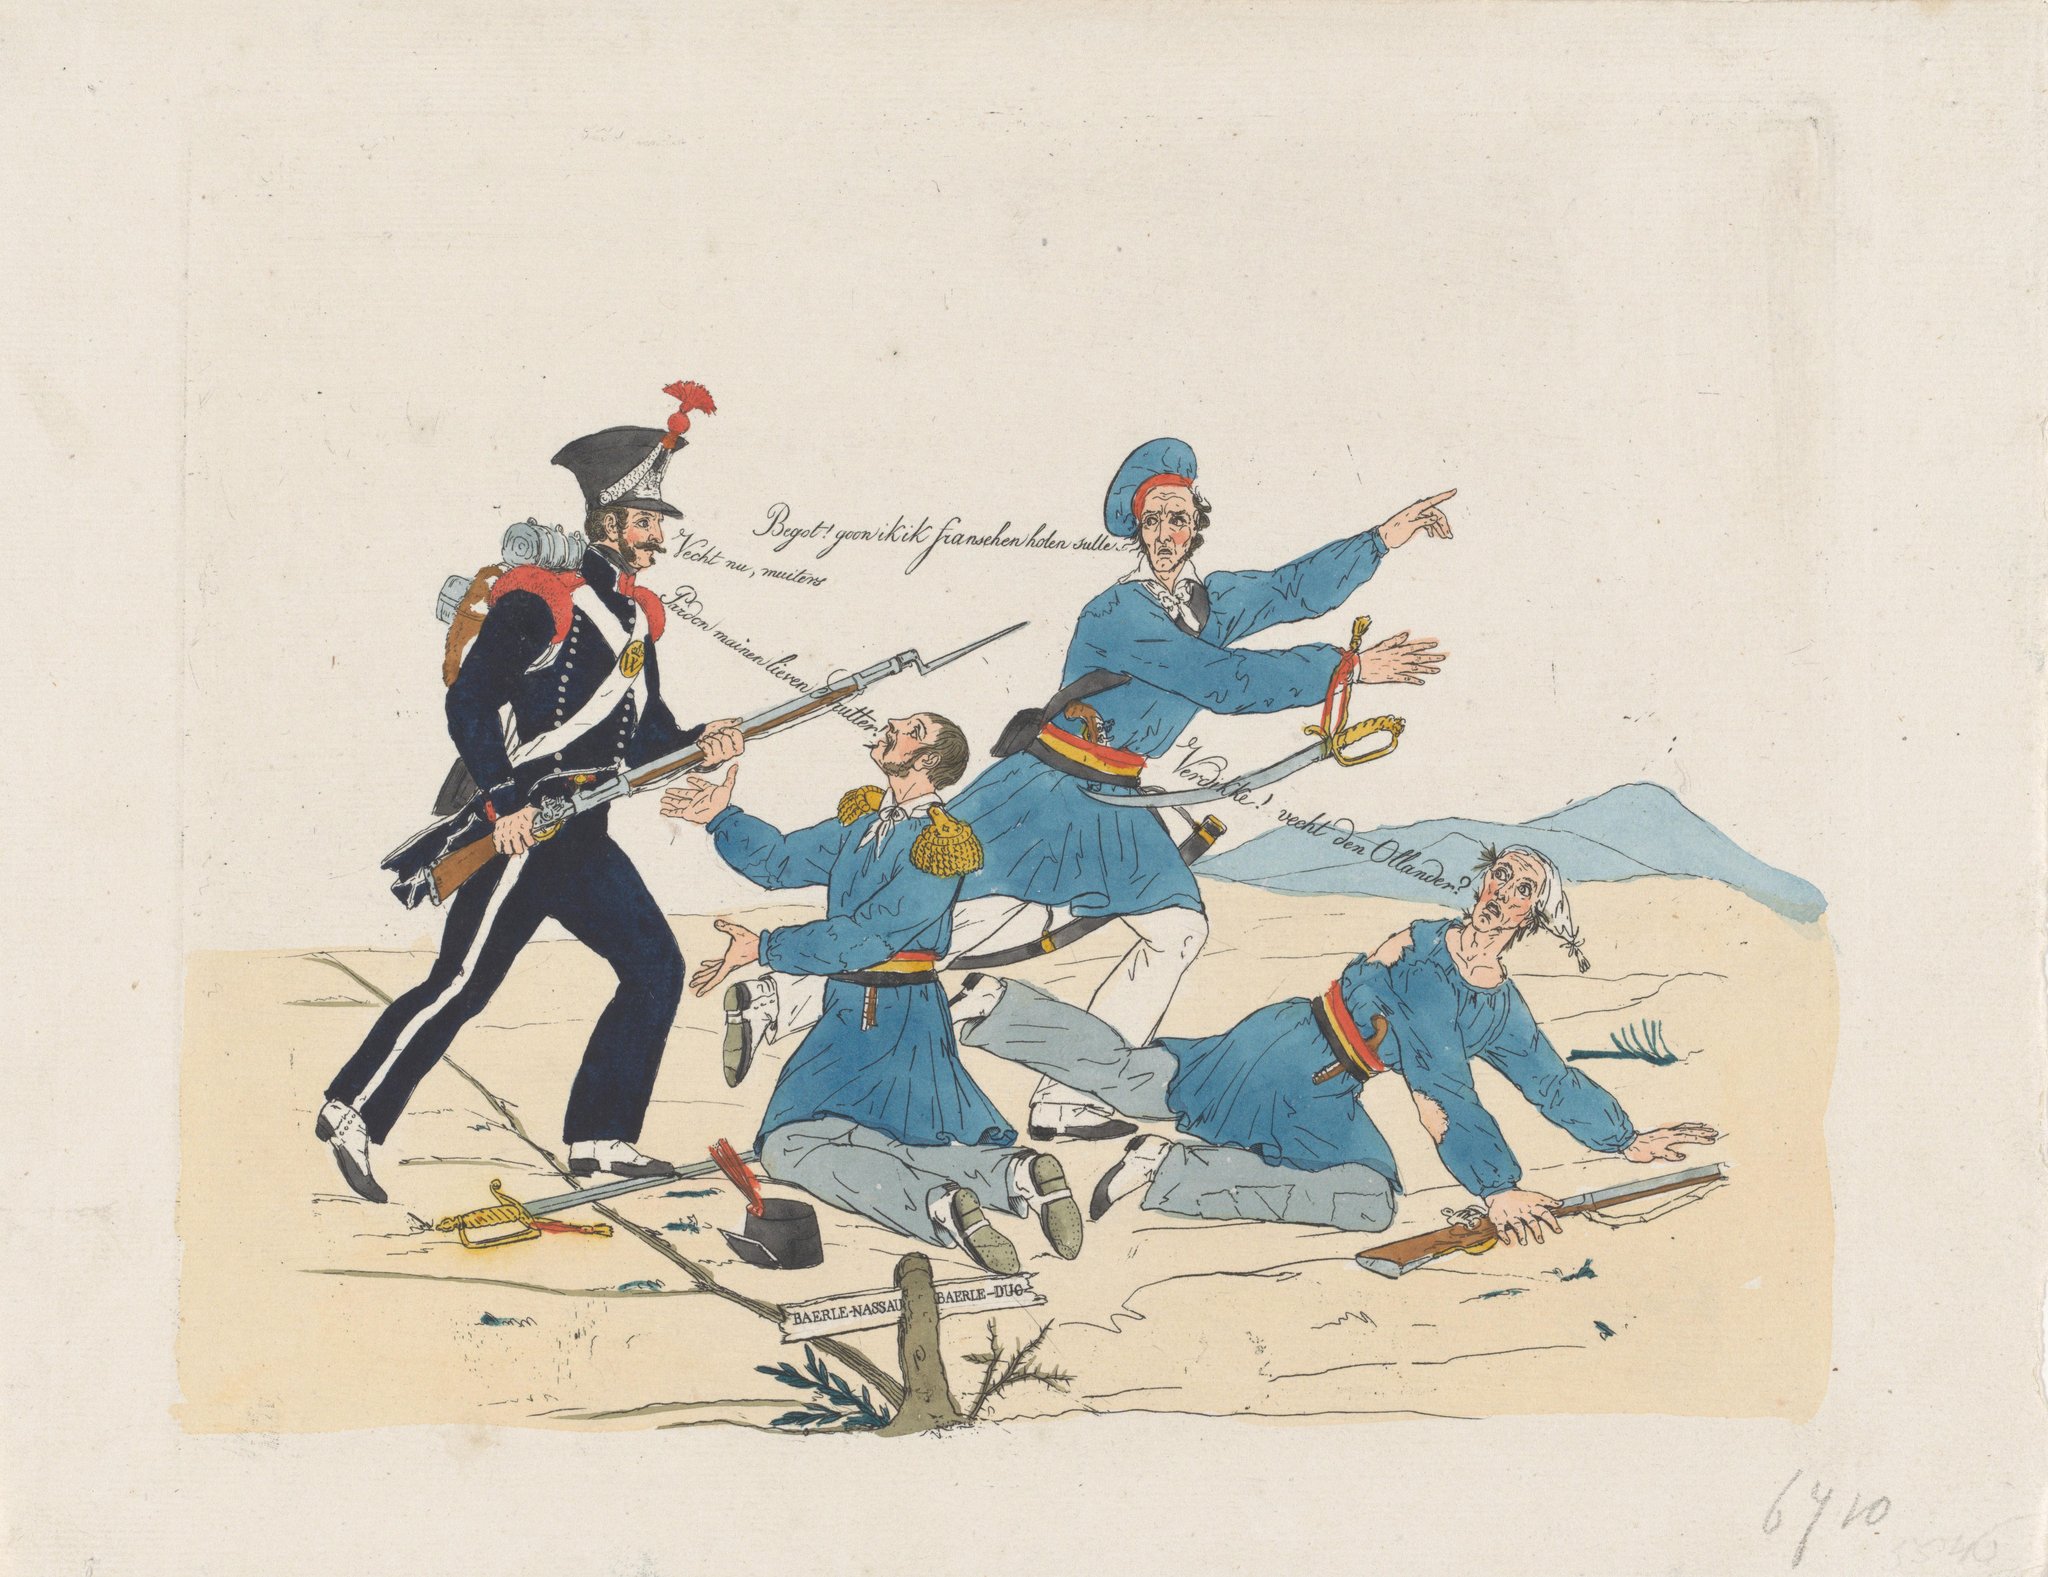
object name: print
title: Spotprent op de gevechten met de Belgen bij Baarle-Nassau, 1831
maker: Anonymous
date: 1831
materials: paper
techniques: hand coloring, lithograph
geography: netherlands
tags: putting the enemy to flight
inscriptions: collector's mark: Lugt 2228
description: Spotprent op de verbaasde Belgen in hun blauwe kielen die verrast worden als de Nederlandse militair over de grens stapt bij Baarle-Nassau/Baarle-Duc. Tijdens de Tiendaagse Veldtocht, 2-12 augustus 1831.